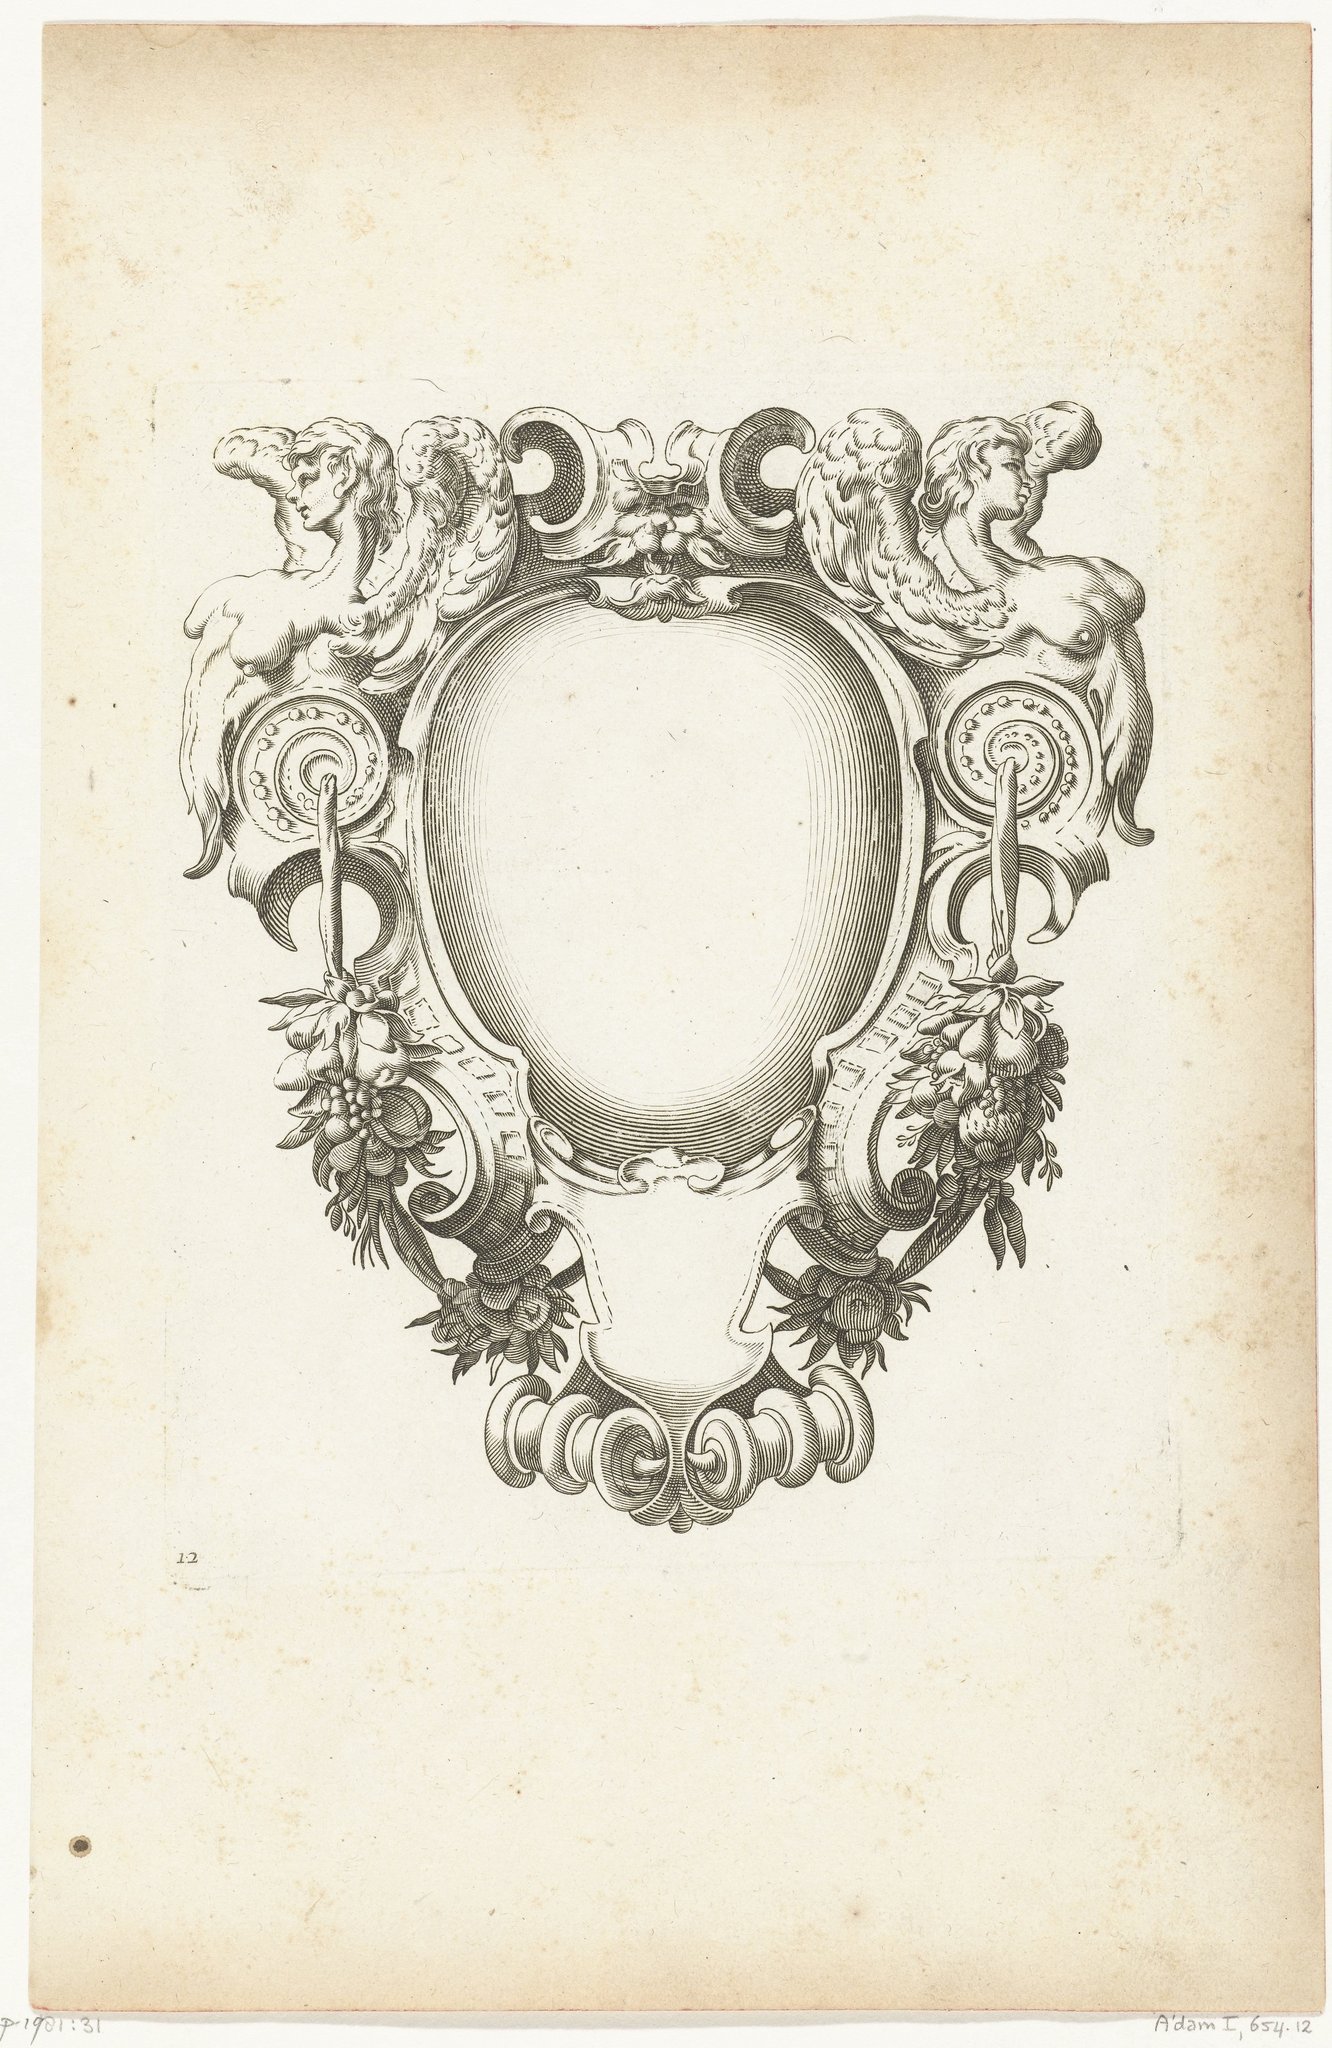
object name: print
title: Cartouche met bovenlichamen van twee gevleugelde vrouwen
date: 1613-1657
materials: paper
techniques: engraving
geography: france